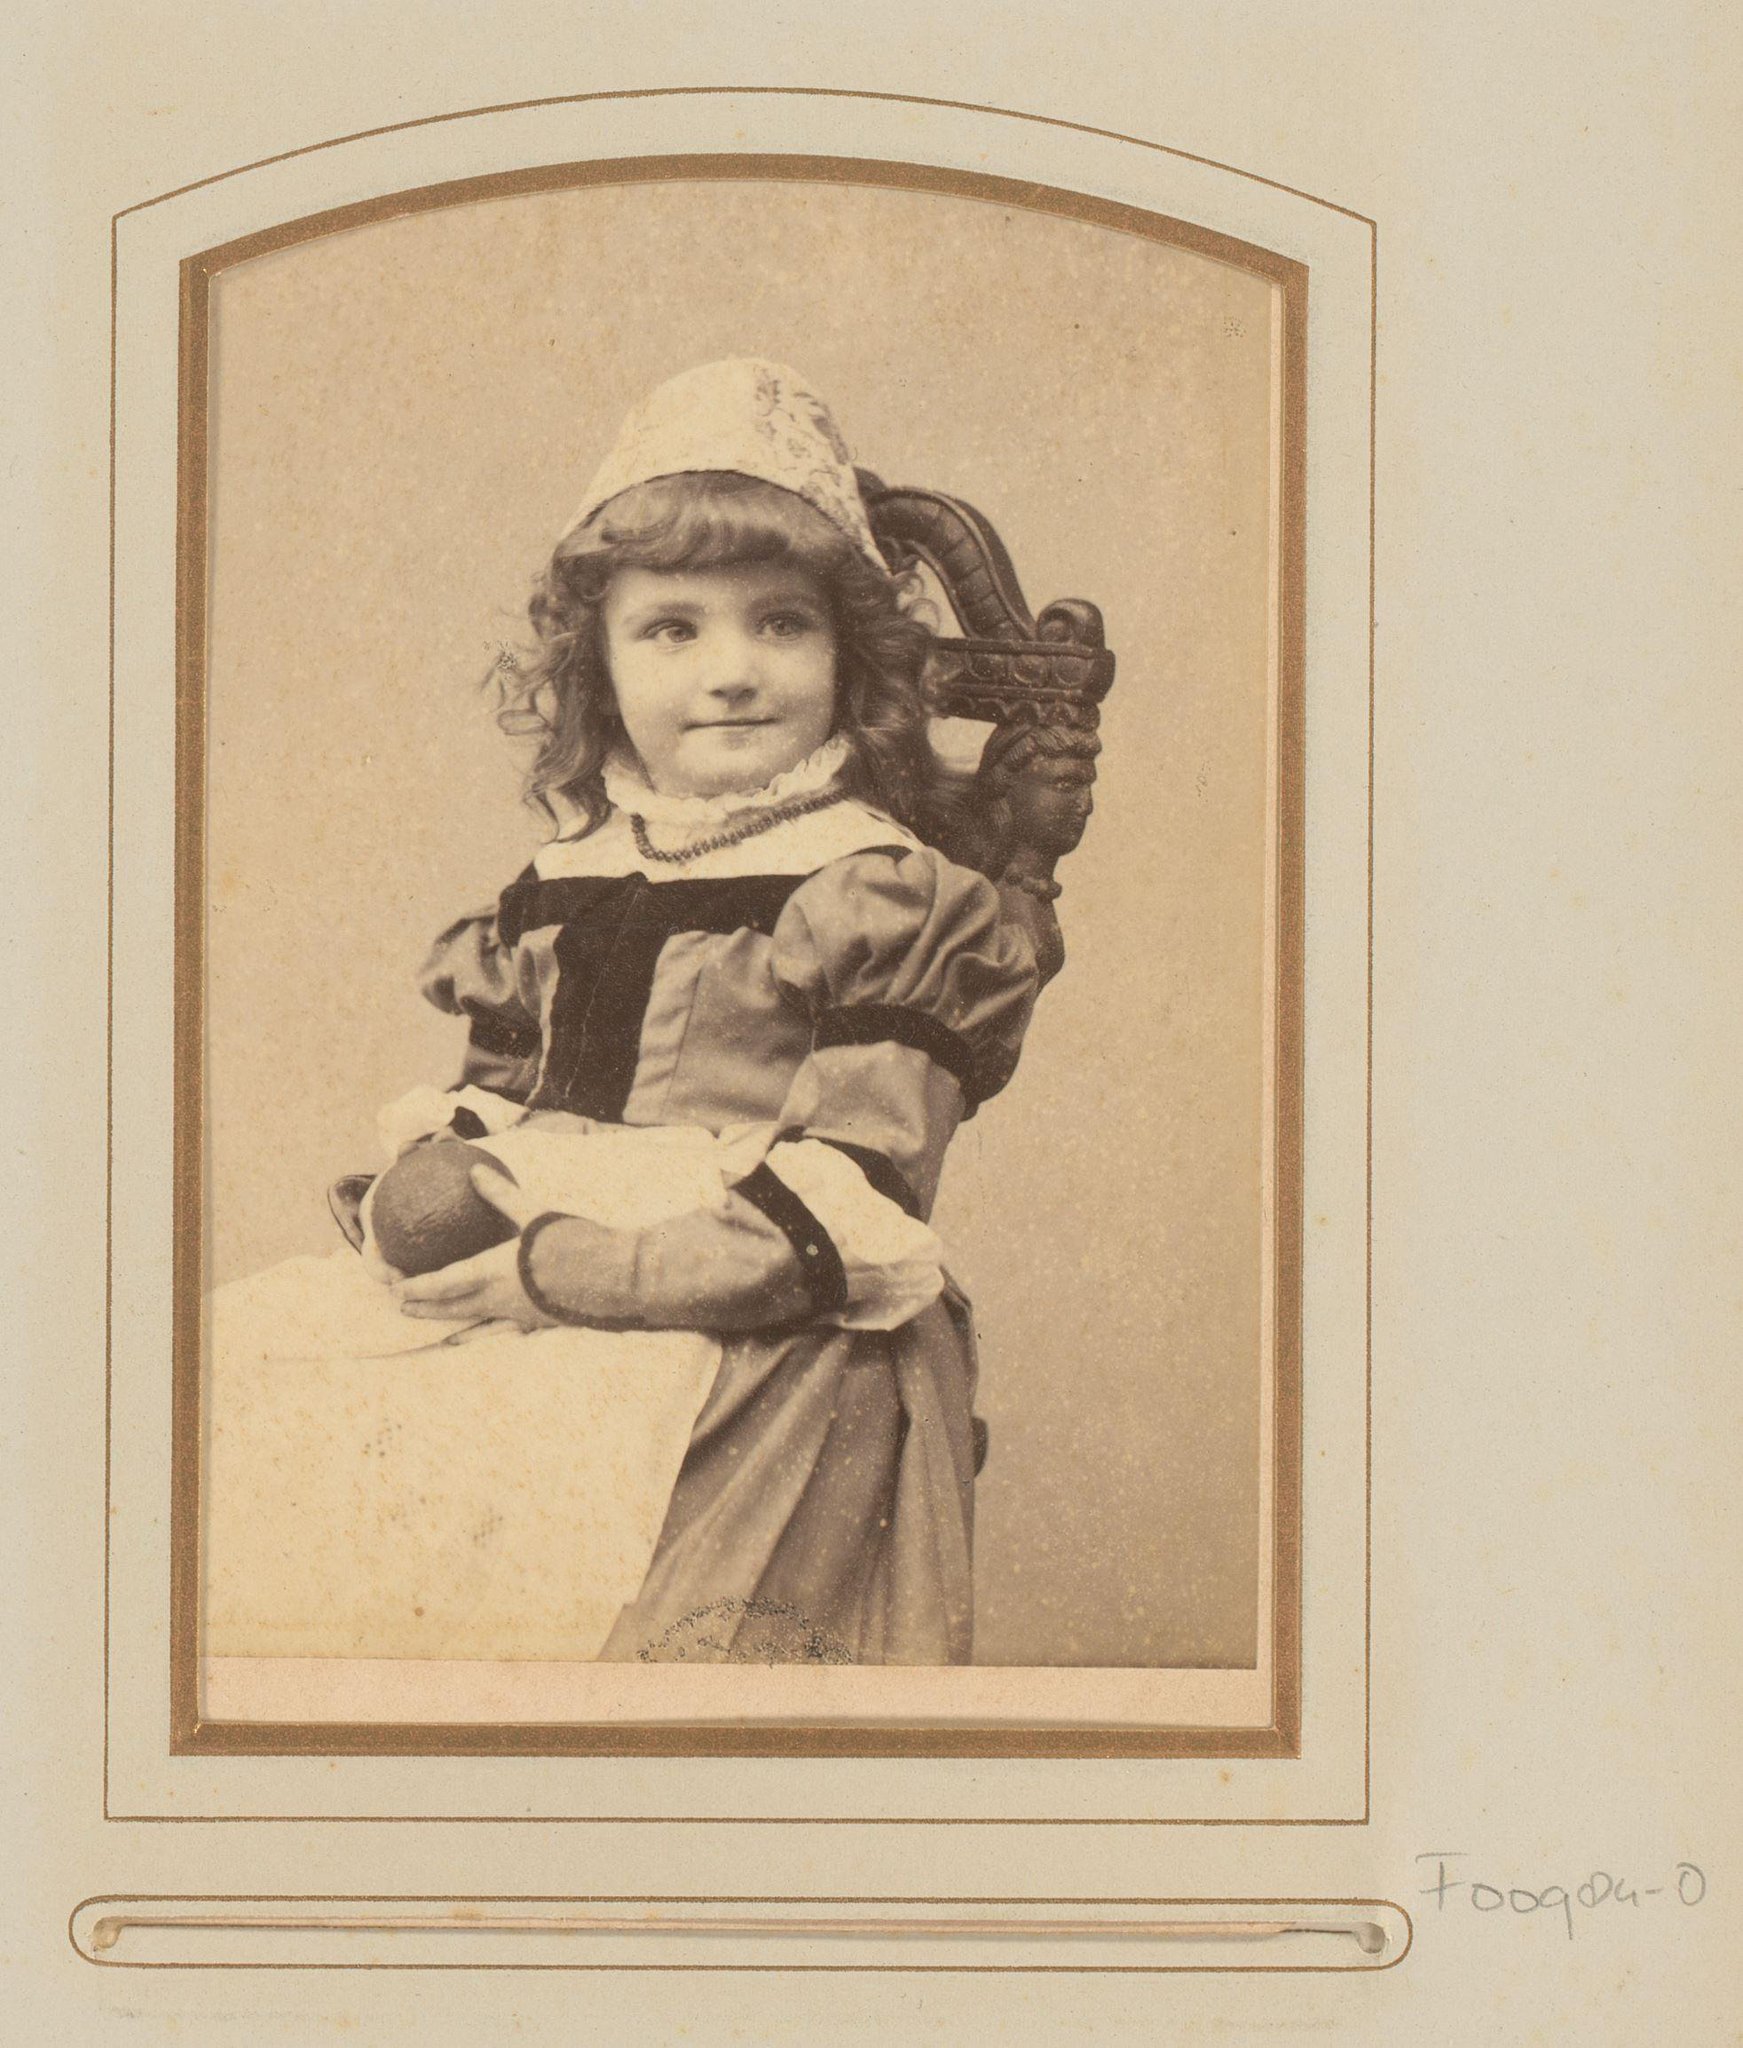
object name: photograph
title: Portret van een zittend meisje in klederdracht met bal in de hand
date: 1886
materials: cardboard, photographic support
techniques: albumen print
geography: berlin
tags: sitting figure - aa - female human figure, historical persons - bb - woman, girl (child between toddler and youth), folk costume, regional costume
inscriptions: inscription: ‘Nr. 359./ Verlag von Sophus Williams, Berlin W.’, inscription: ‘Phot. u. Verlag/ Frau E. Vogelsang/ 1886./ Leipziger-Strasse/ Berlin.’